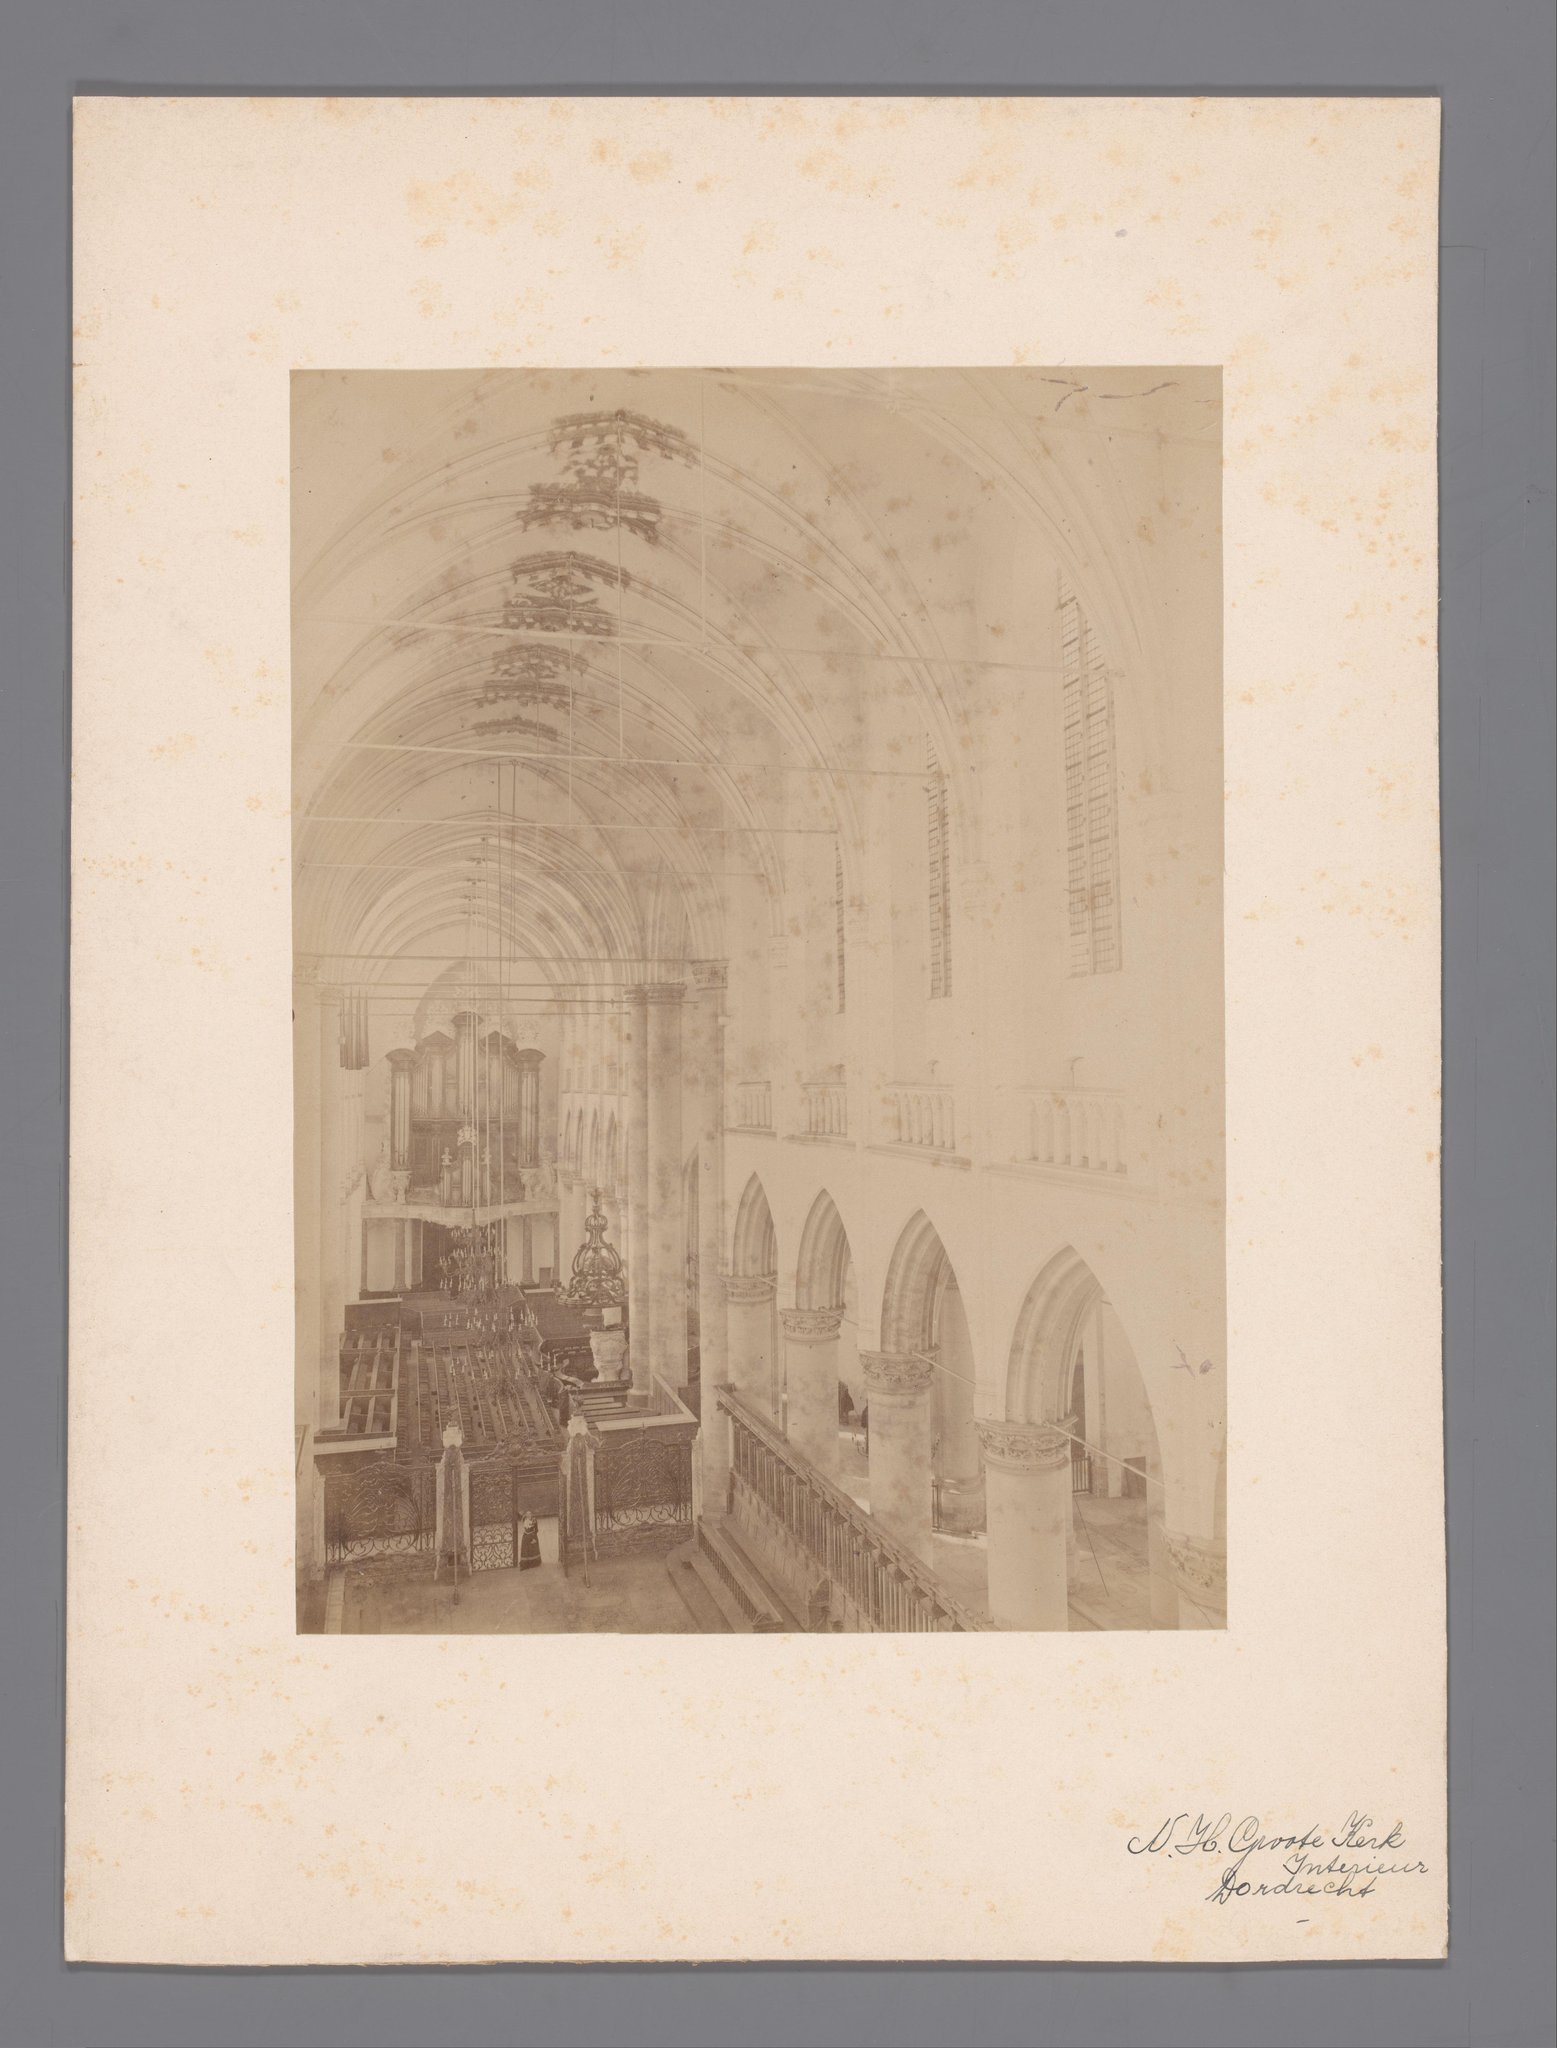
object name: photograph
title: Interieur van de Grote of Onze-Lieve-Vrouwenkerk te Dordrecht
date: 1880-1910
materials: cardboard, photographic support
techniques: albumen print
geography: grote of onze-lieve-vrouwekerk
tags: interior of church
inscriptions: annotation: ‘N.H. Groote Kerk/ Interieur/ Dordrecht’, annotation: ‘Dordrecht/ Interieur der kerk’